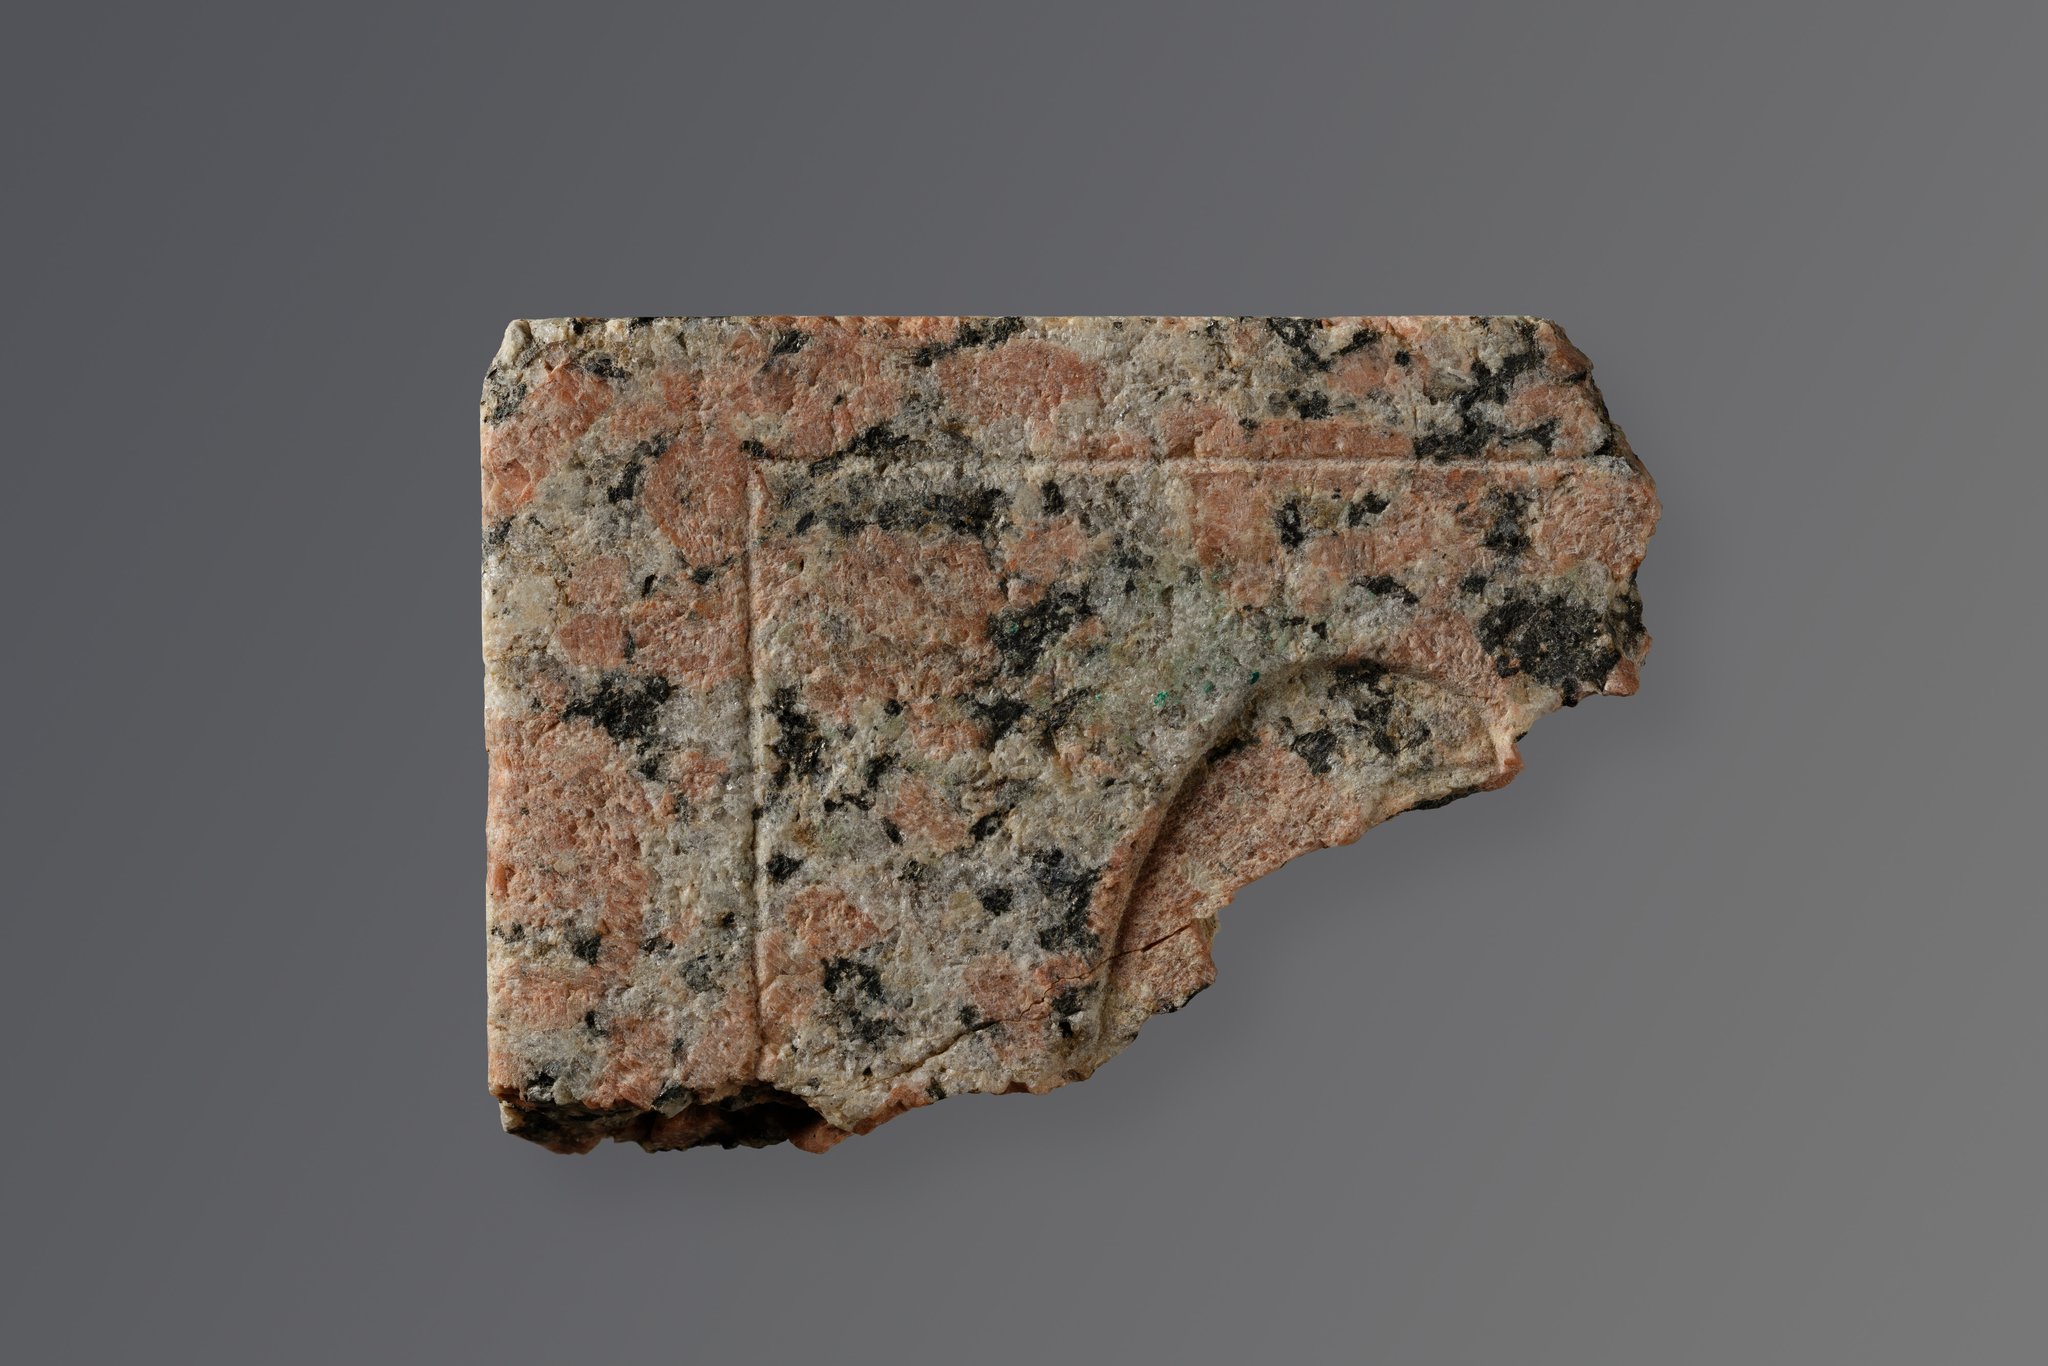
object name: relief fragment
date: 1981-1640 BCE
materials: granite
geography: egypt